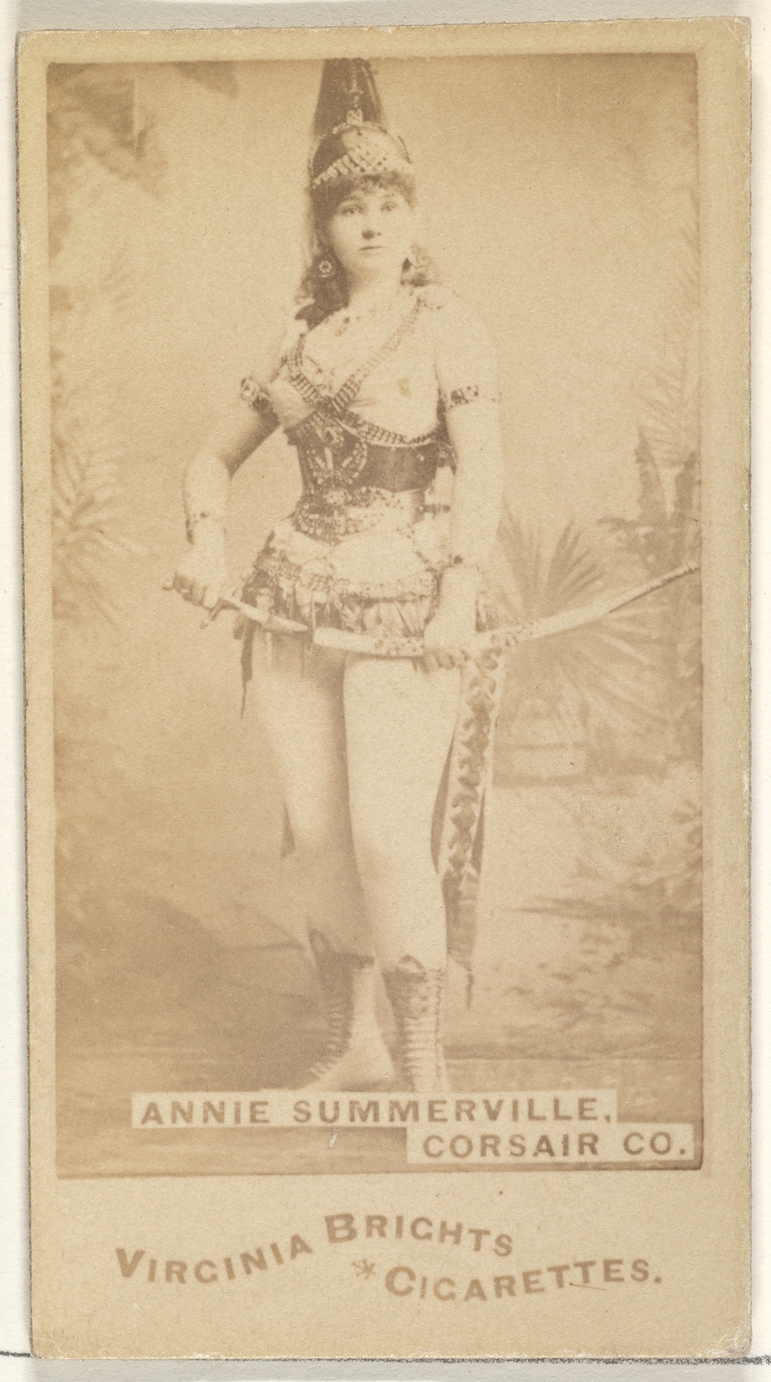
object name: photograph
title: Annie Summerville, Corsair Co., from the Actors and Actresses series (N45, Type 1) for Virginia Brights Cigarettes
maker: allen & ginter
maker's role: publisher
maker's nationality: american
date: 1888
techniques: albumen silver print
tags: portraits,women,actresses